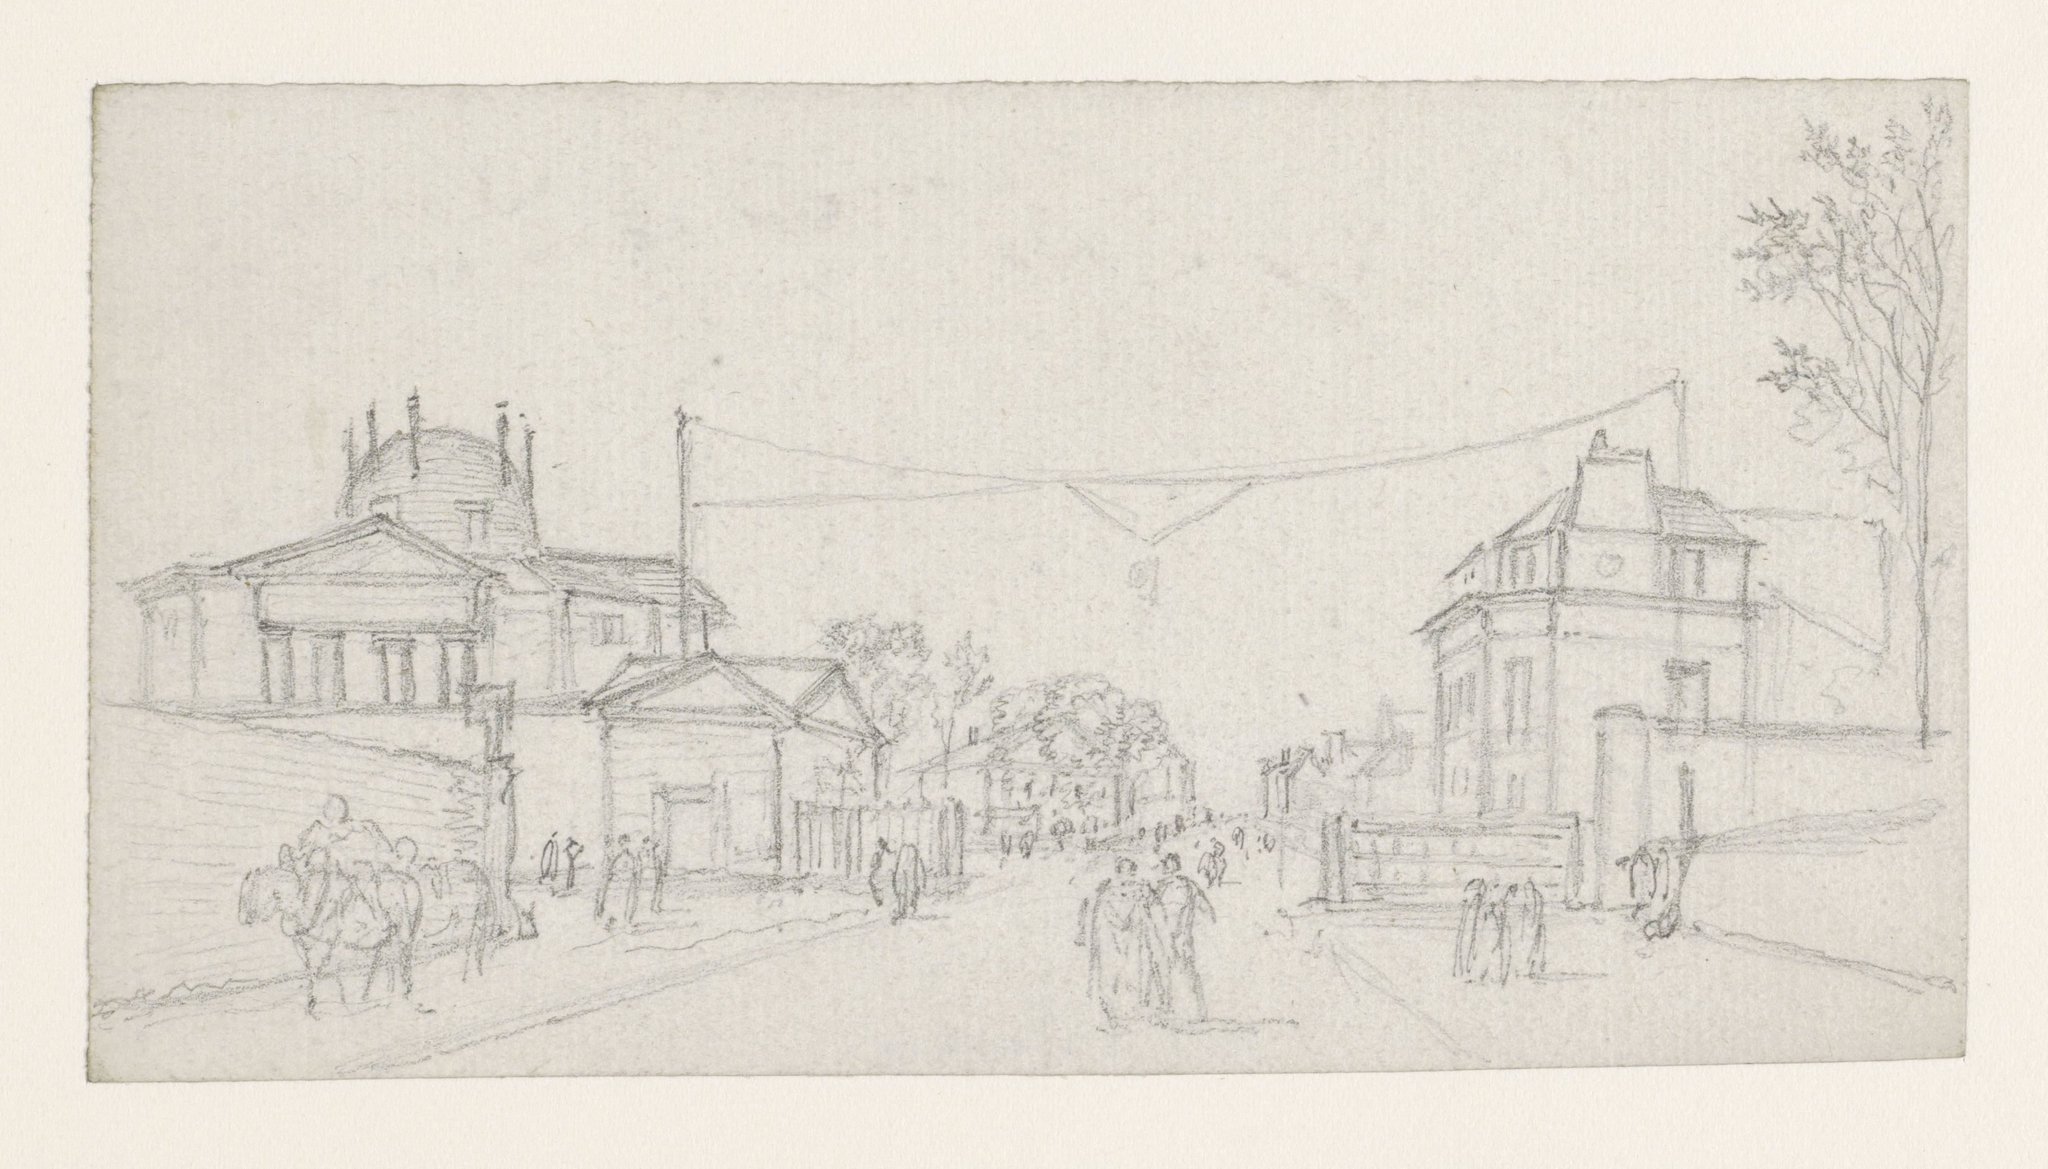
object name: drawing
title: Een van de Barrières van Parijs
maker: georges michel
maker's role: draughtsman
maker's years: 1763-1843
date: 1773-1843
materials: paper, pencil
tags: public road (+ city(-scape) with figures, staffage)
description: Een van 120 tekeningen, afkomstig uit een 19e eeuws album met tekeningen van Georges Michel.